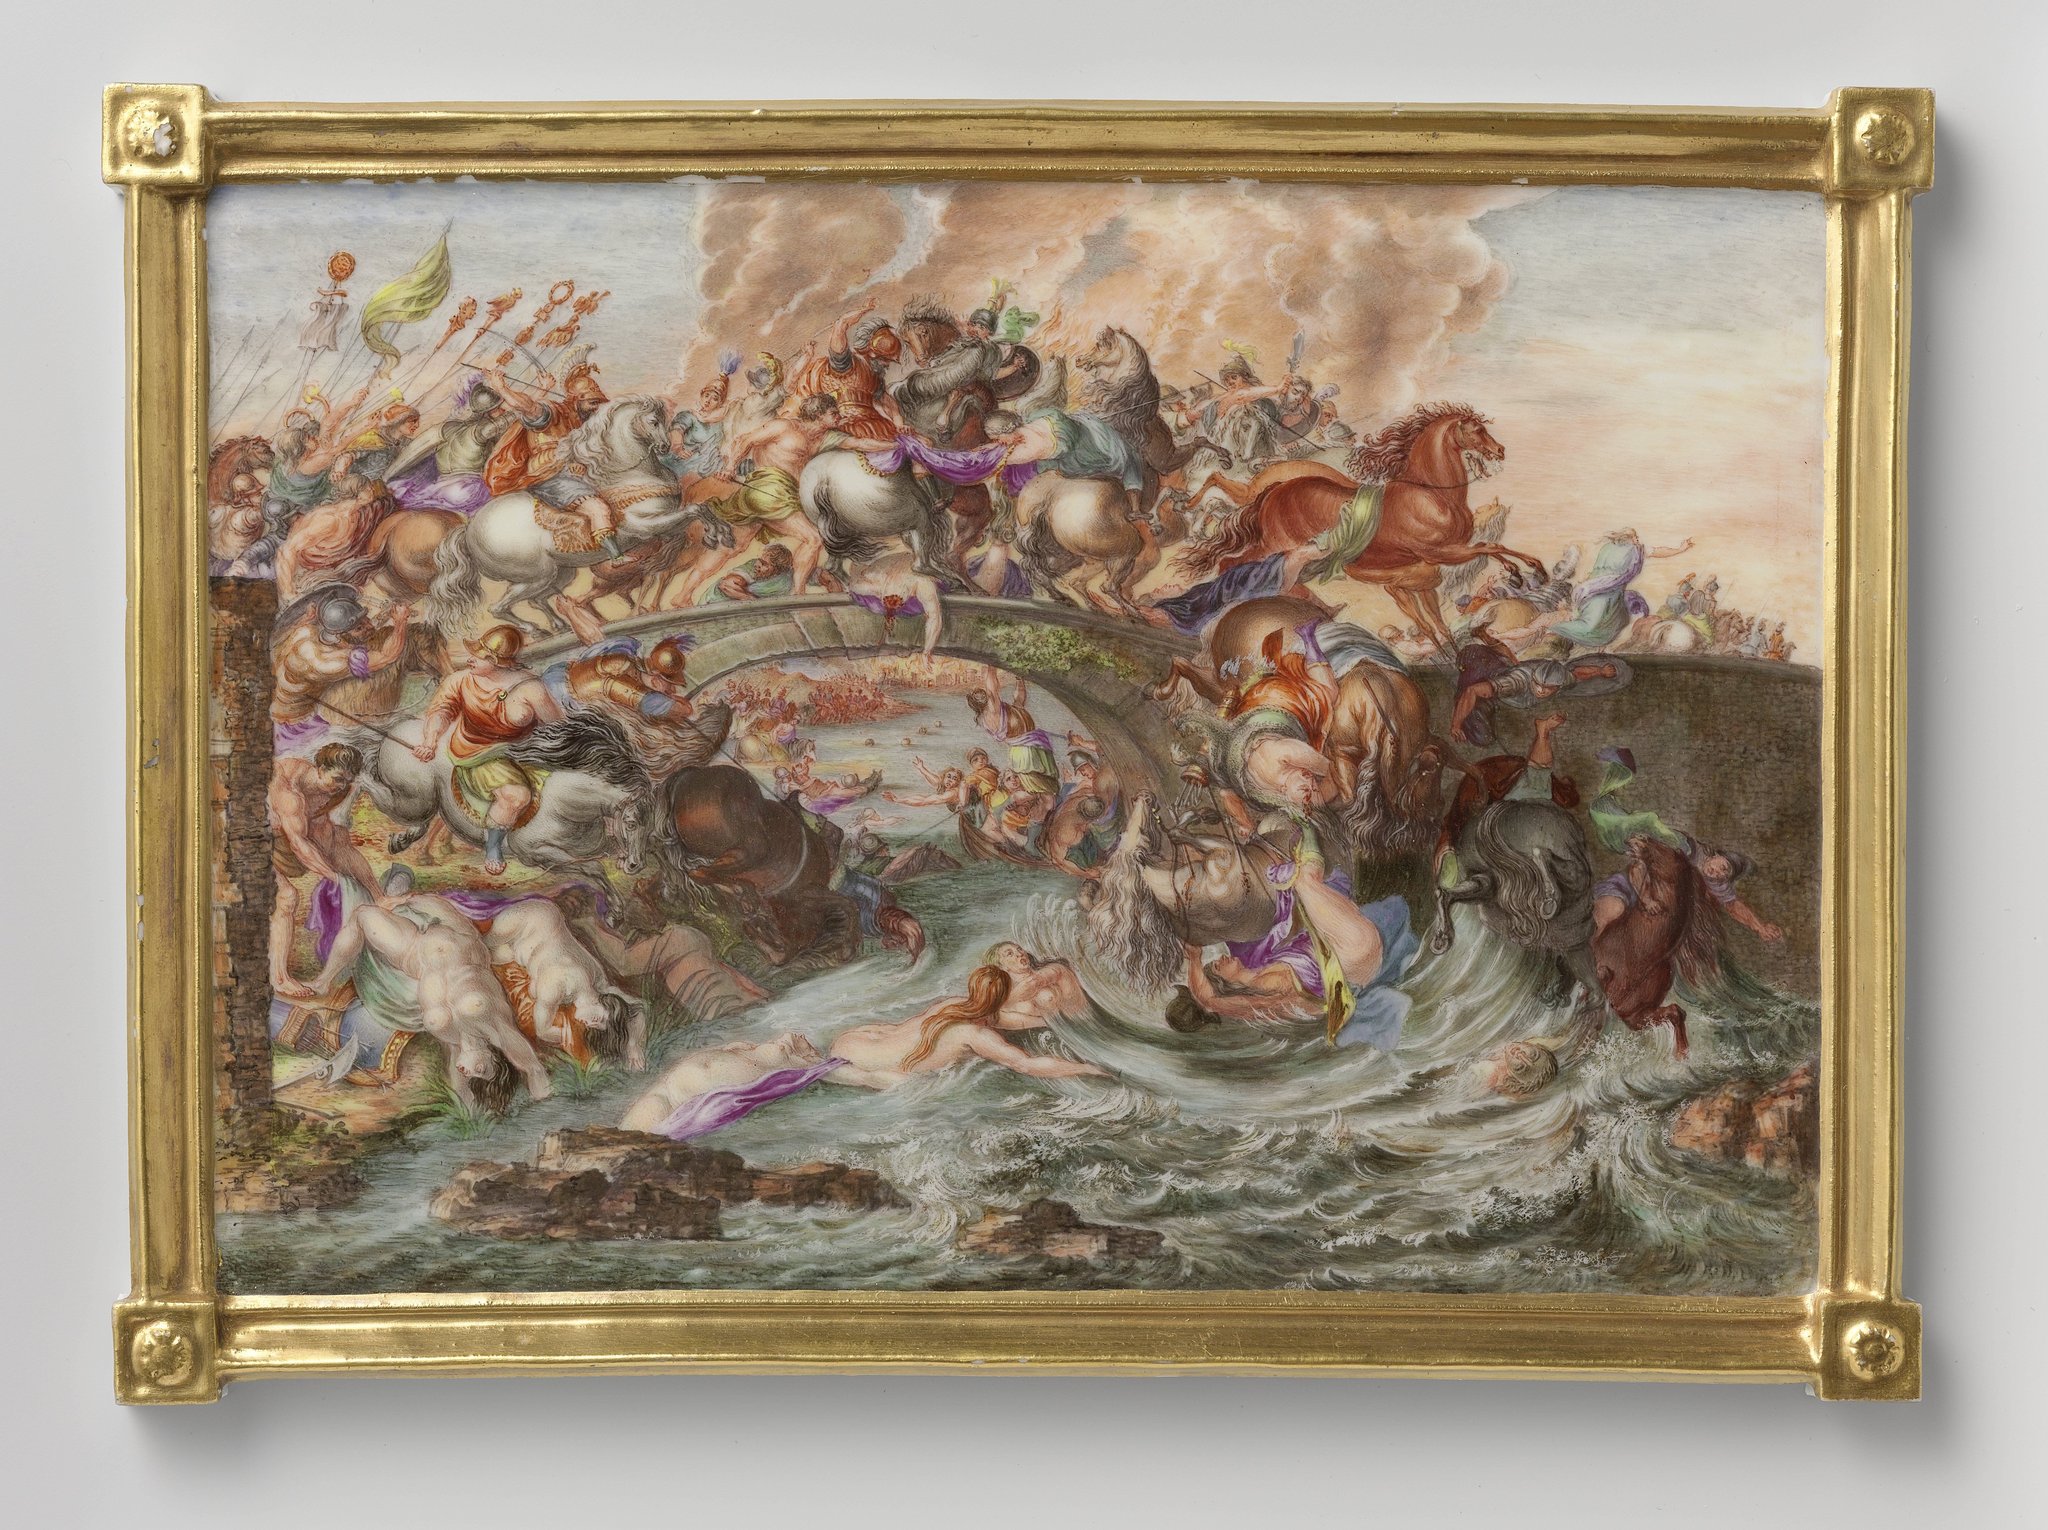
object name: plate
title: Plaque with the Battle of the Amazons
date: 1778-1782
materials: porcelain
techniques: painted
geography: loosdrecht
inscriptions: factory mark: ‘M:OL met ster’, factory mark: ‘M:OL met ster’, mark: ‘LI en B’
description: Painted porcelain plaques fired together with their frames are rare. While they occur with some frequency in earthenware, only a very few porcelain factories produced these kinds of little ‘paintings’. This depiction is based on a painting by Peter Paul Rubens. It is a spectacular jumble of fighting female warriors (the Amazons) and Greek soldiers under the command of Theseus.